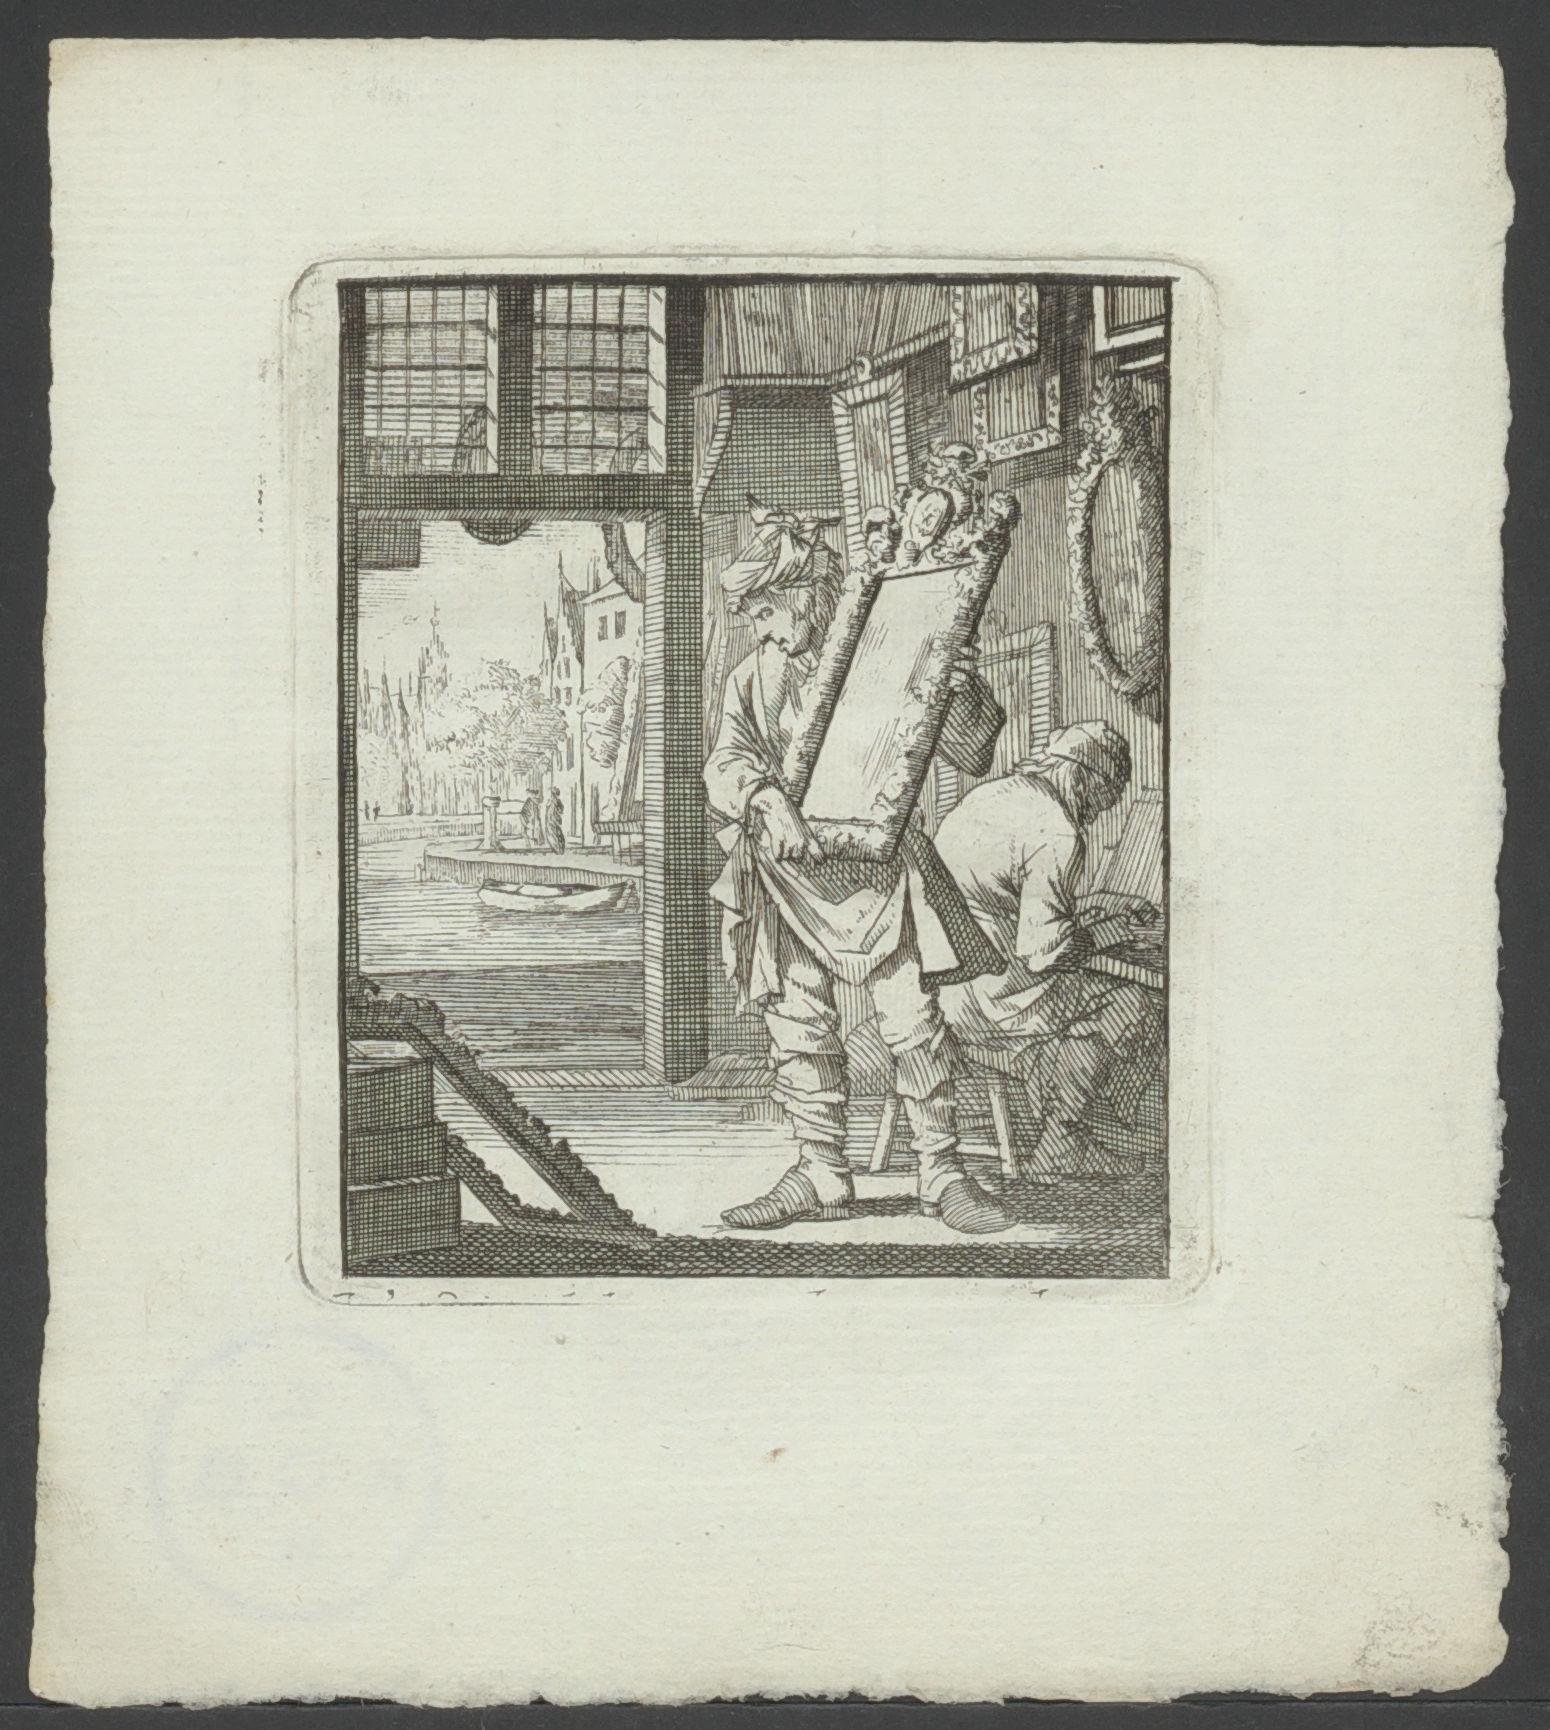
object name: print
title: Spiegelmaker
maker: Anonymous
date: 1694-1799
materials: paper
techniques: engraving, etching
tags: mirror-maker, handicrafts, craftsman at work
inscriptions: collector's mark: Lugt 1641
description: Onderwerpsrubrieken binnen de Atlas Zeden en Gewoonten: Handel, Nijverheid en Verkeer, Beroep en bedrijf, Complete suites.